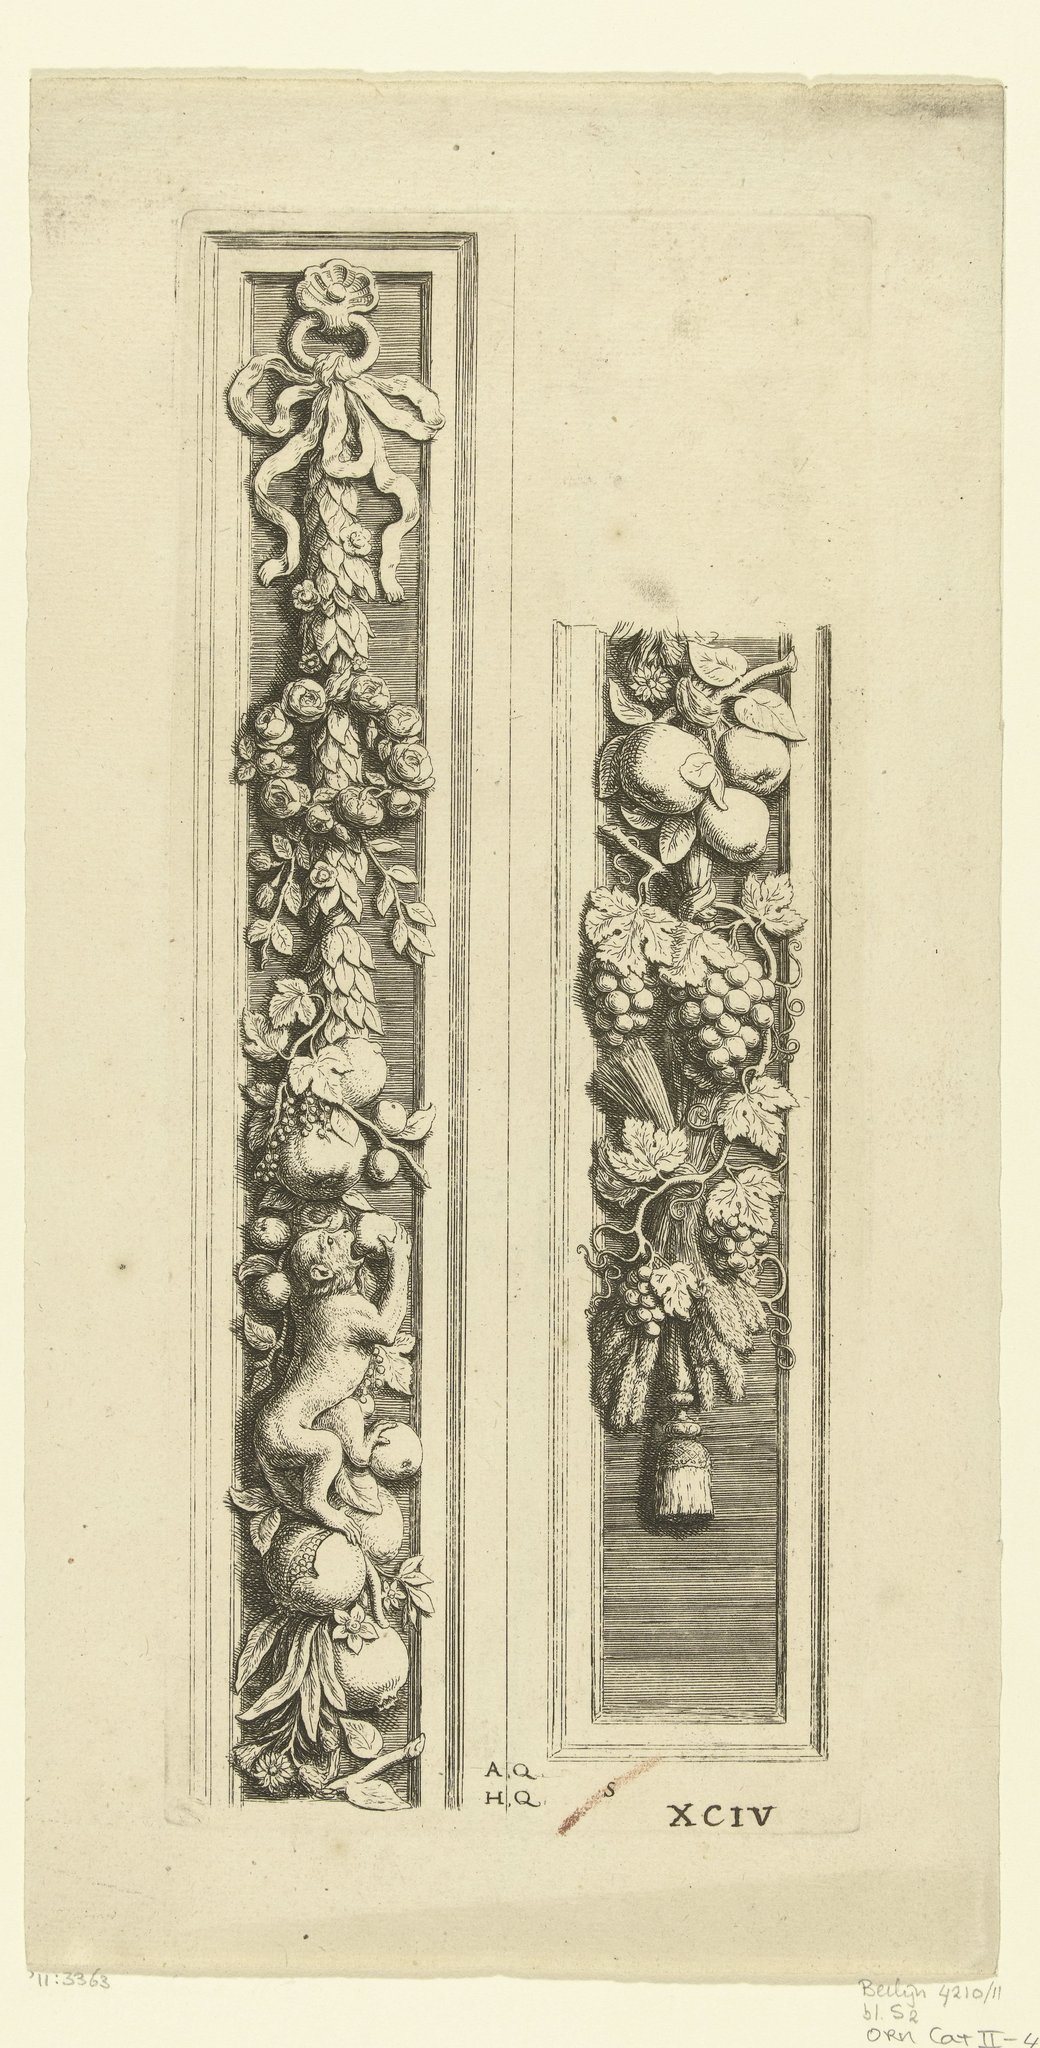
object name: print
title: Prima Pars Praecipuarum (...)/ Het Eerste Deel Van de voornaemste Statuen ende Cieraten (...)/ La Premier Parti (...)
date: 1665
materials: paper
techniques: etching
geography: amsterdam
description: Blad S [2]. Linksonder zit een aapje. Blad uit tweede editie.